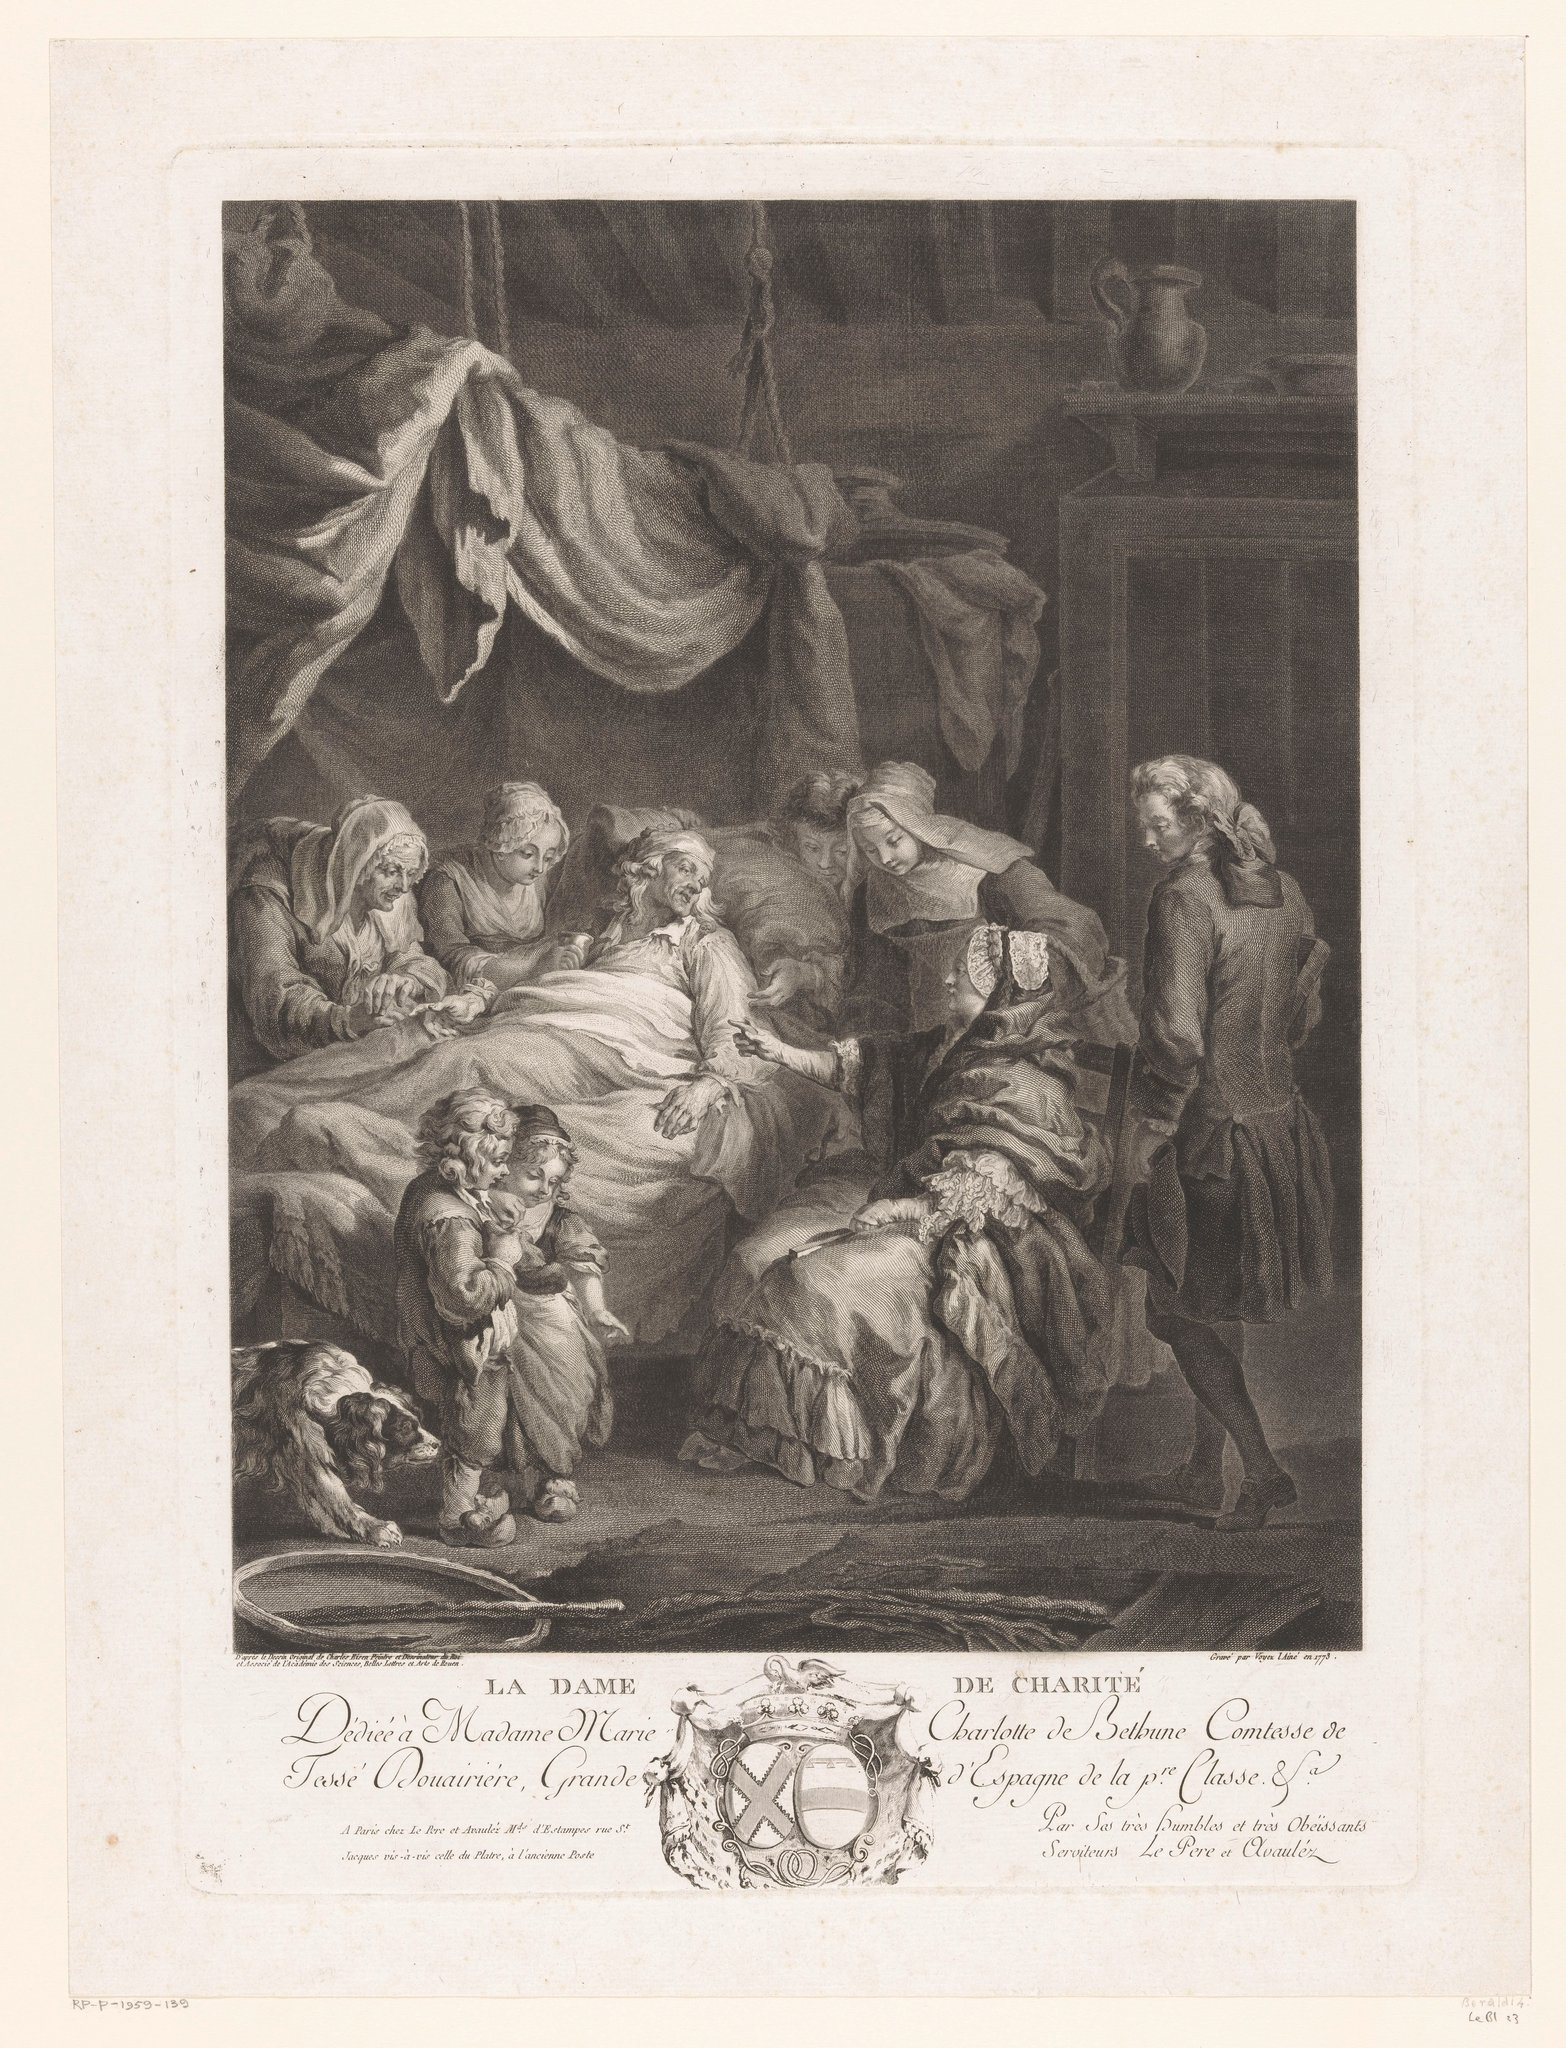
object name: print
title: La Dame de Charité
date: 1773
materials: paper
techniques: engraving, etching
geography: france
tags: giving alms or other charity, e.g.: handing out food, sick-bed, interior of the house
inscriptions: collector's mark: Lugt 2228, collector's mark: Lugt 2760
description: Een oude man ligt in bed in een armoedig interieur, omgeven door familieleden en een zuster. Op een stoel naast zijn bed zit een vrouw van hogere afkomst, die hem een buideltje aanbiedt.